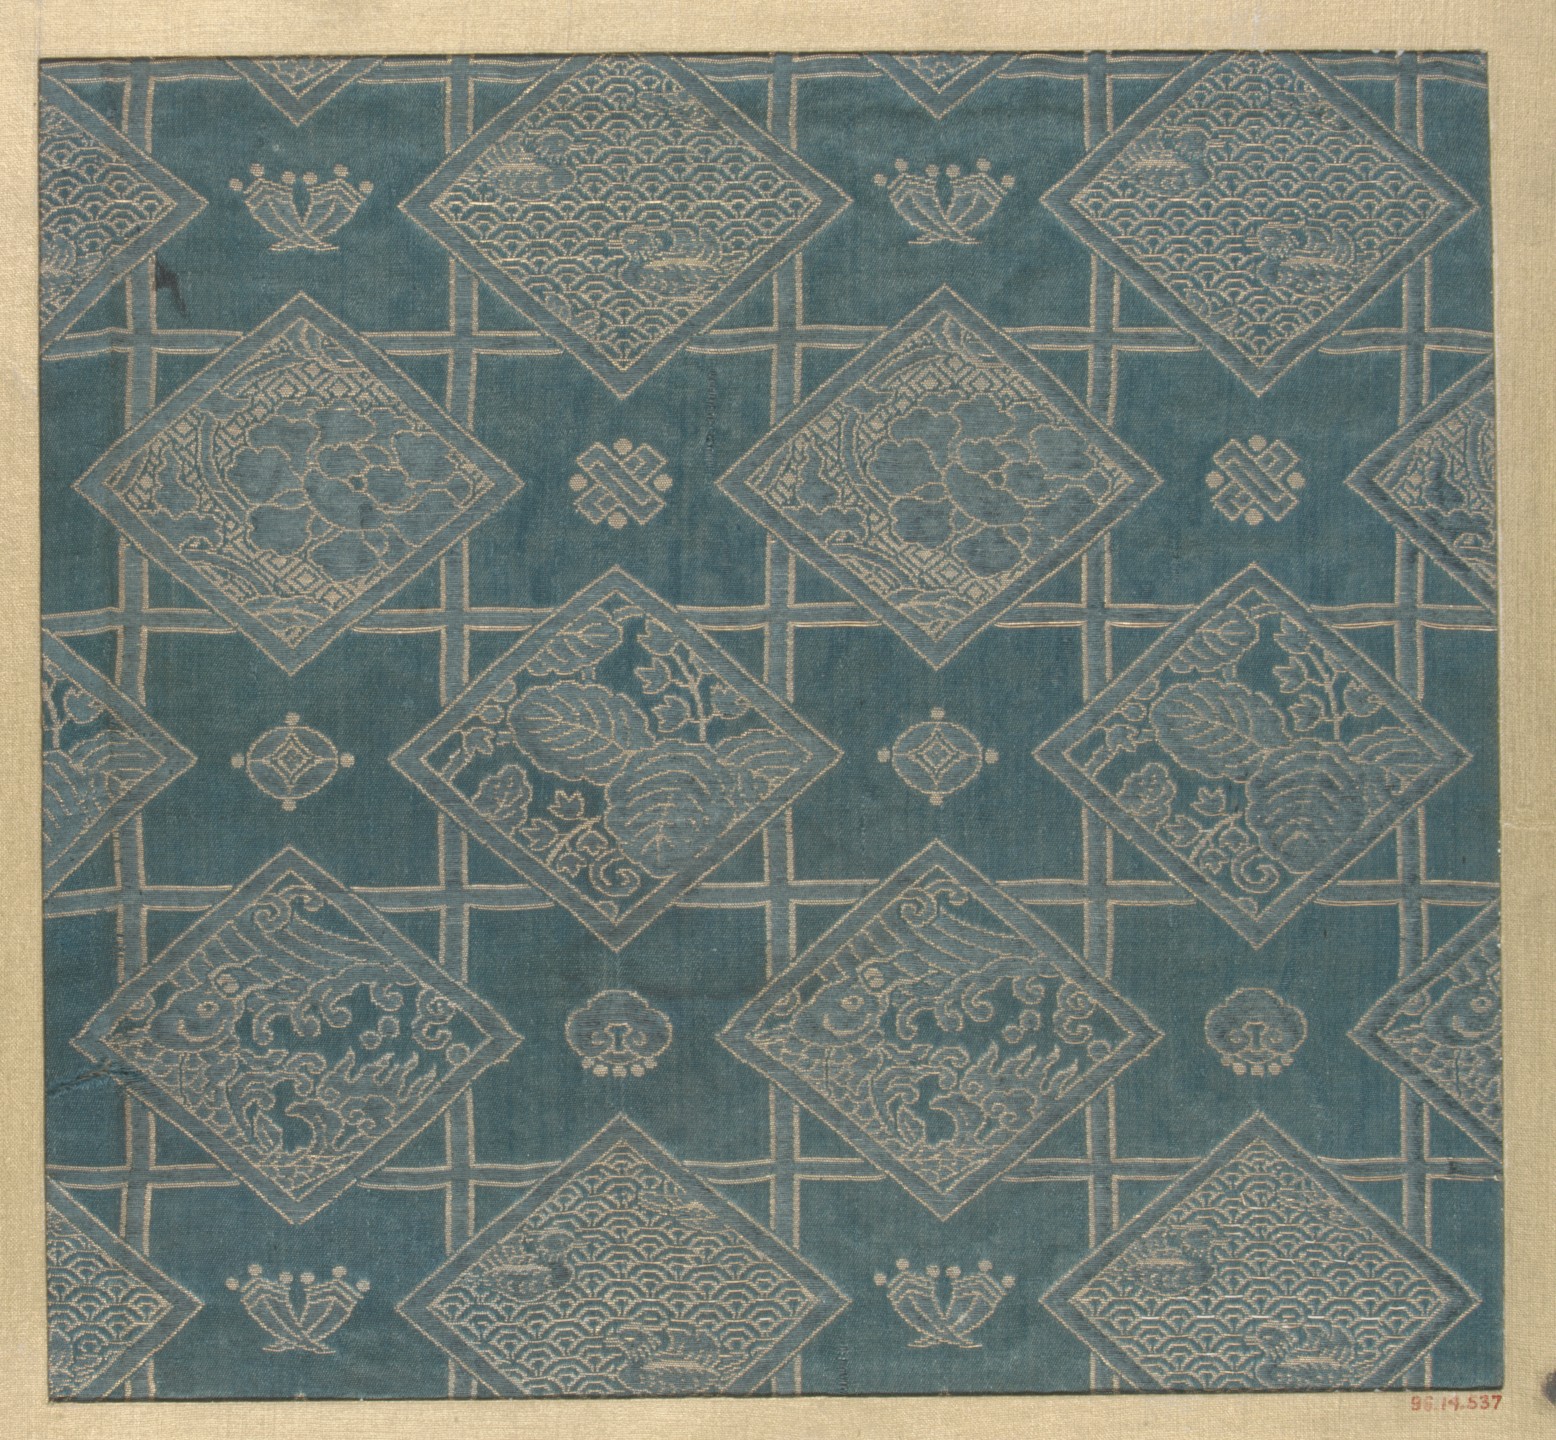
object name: piece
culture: japanese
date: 1701-1900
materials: silk